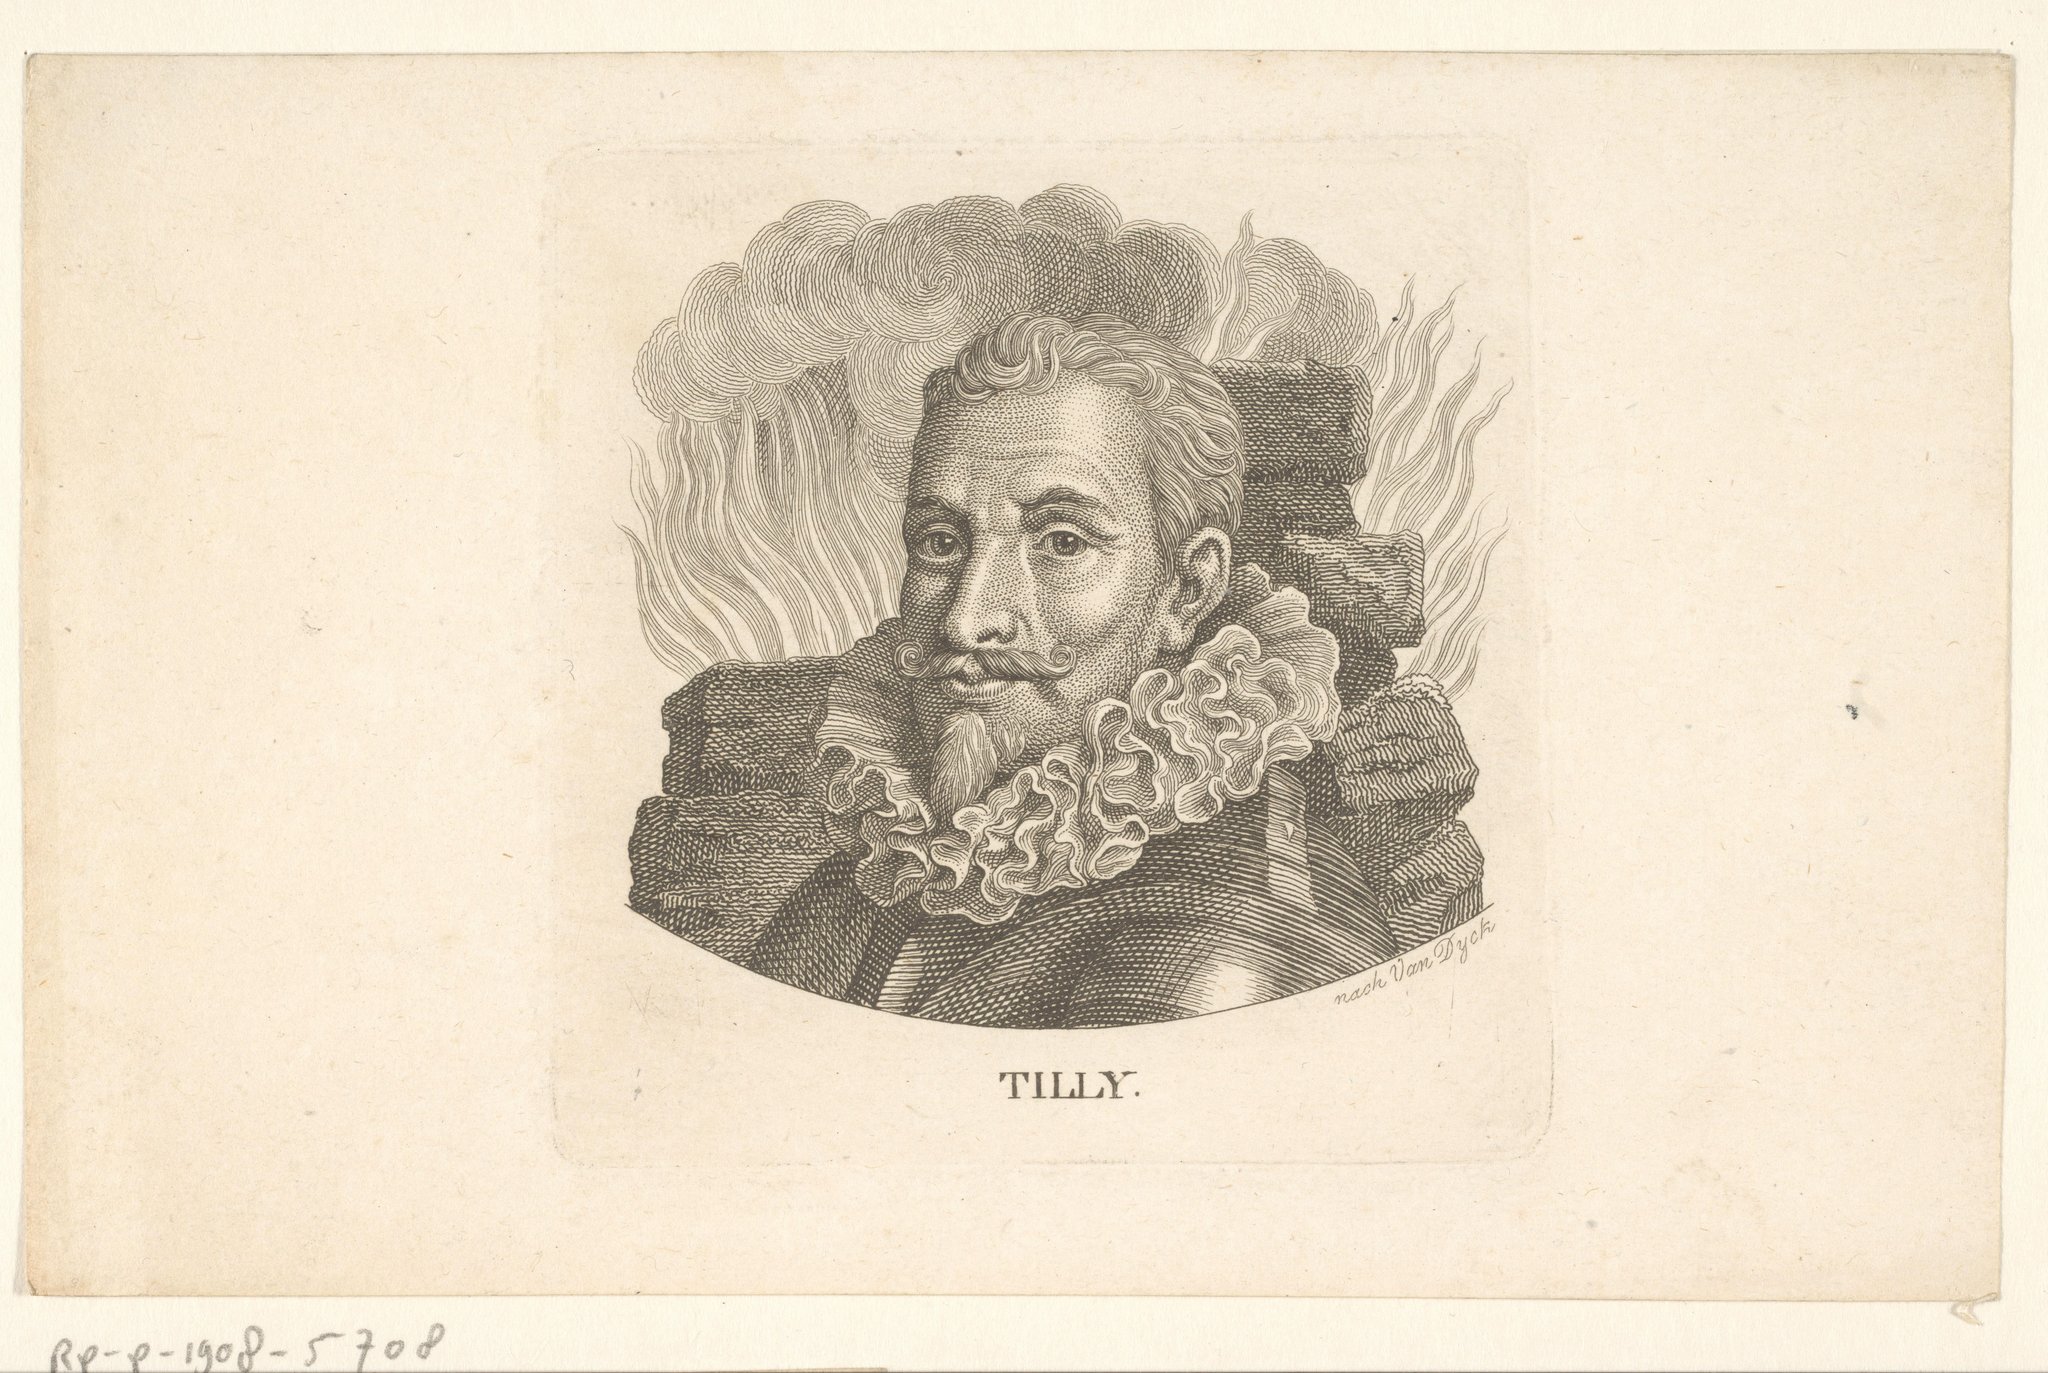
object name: print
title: Portret van Johan 't Serclaes, graaf van Tilly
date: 1775-1840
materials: paper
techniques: engraving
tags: armour, historical persons, devastated, ruined place or city (~ warfare)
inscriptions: collector's mark: Lugt 2228